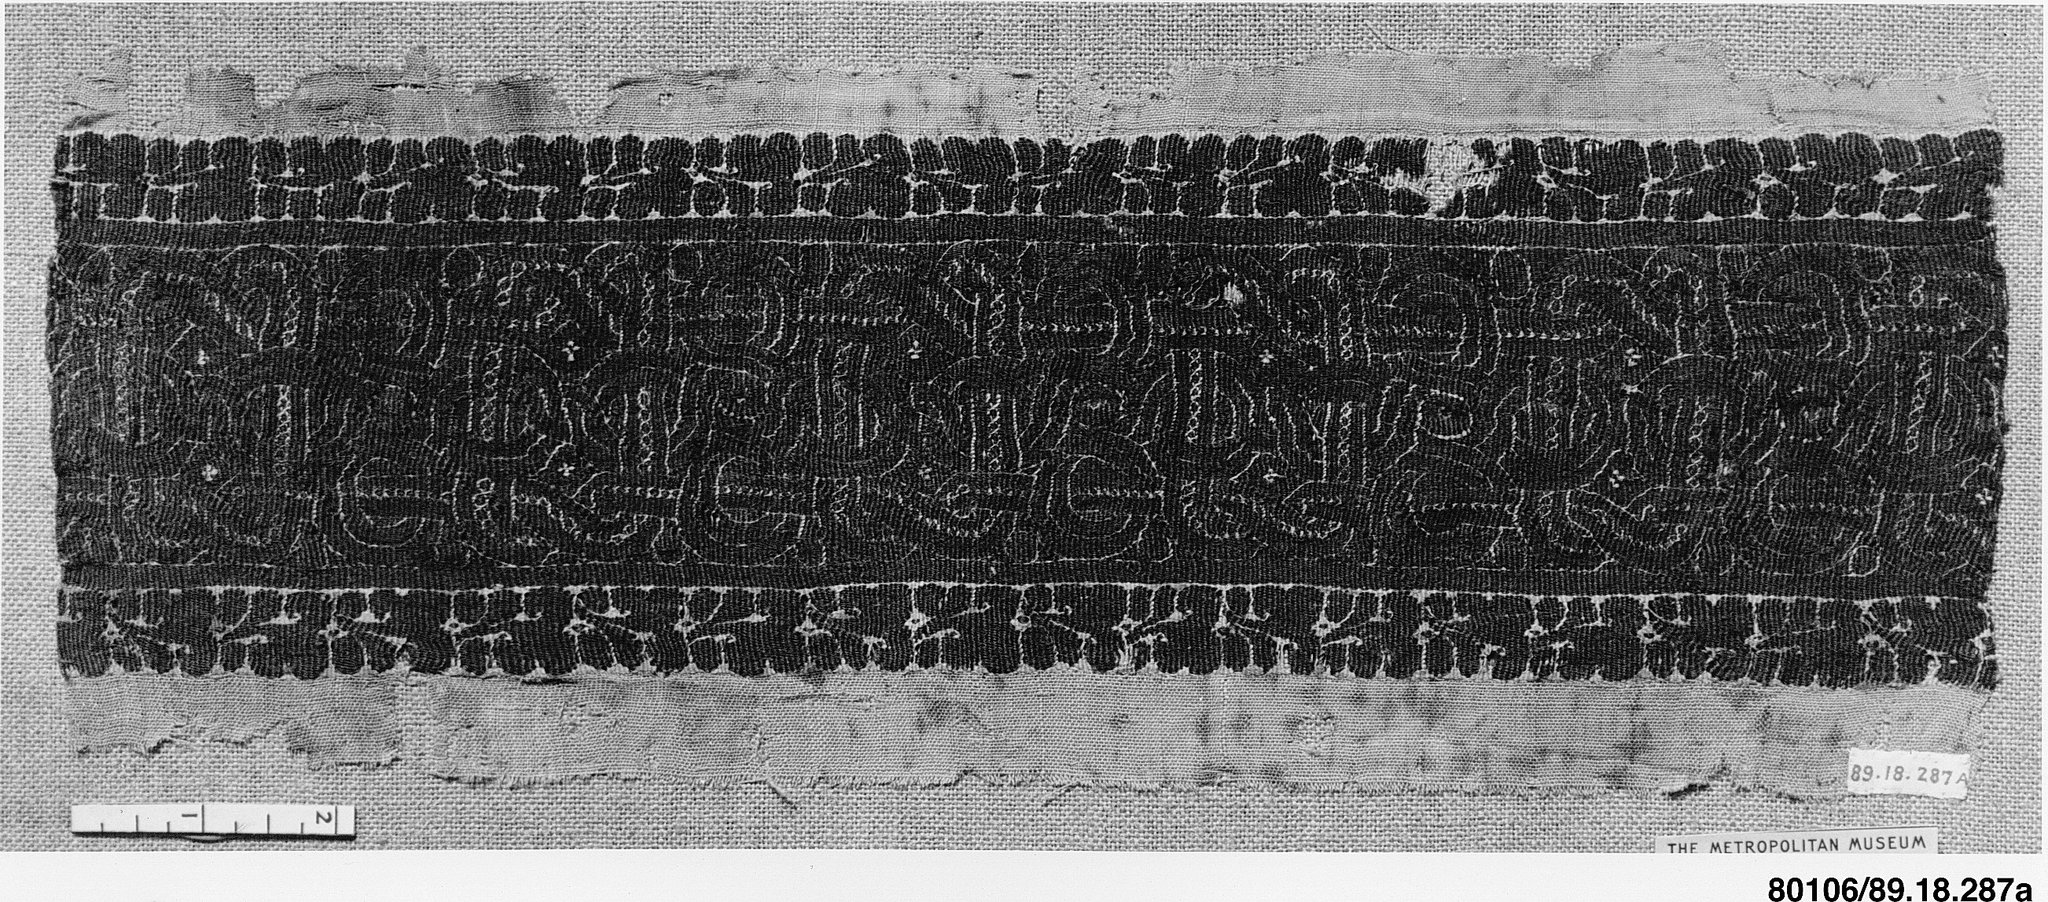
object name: textile fragment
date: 201-400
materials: linen, wool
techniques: weave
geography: egypt